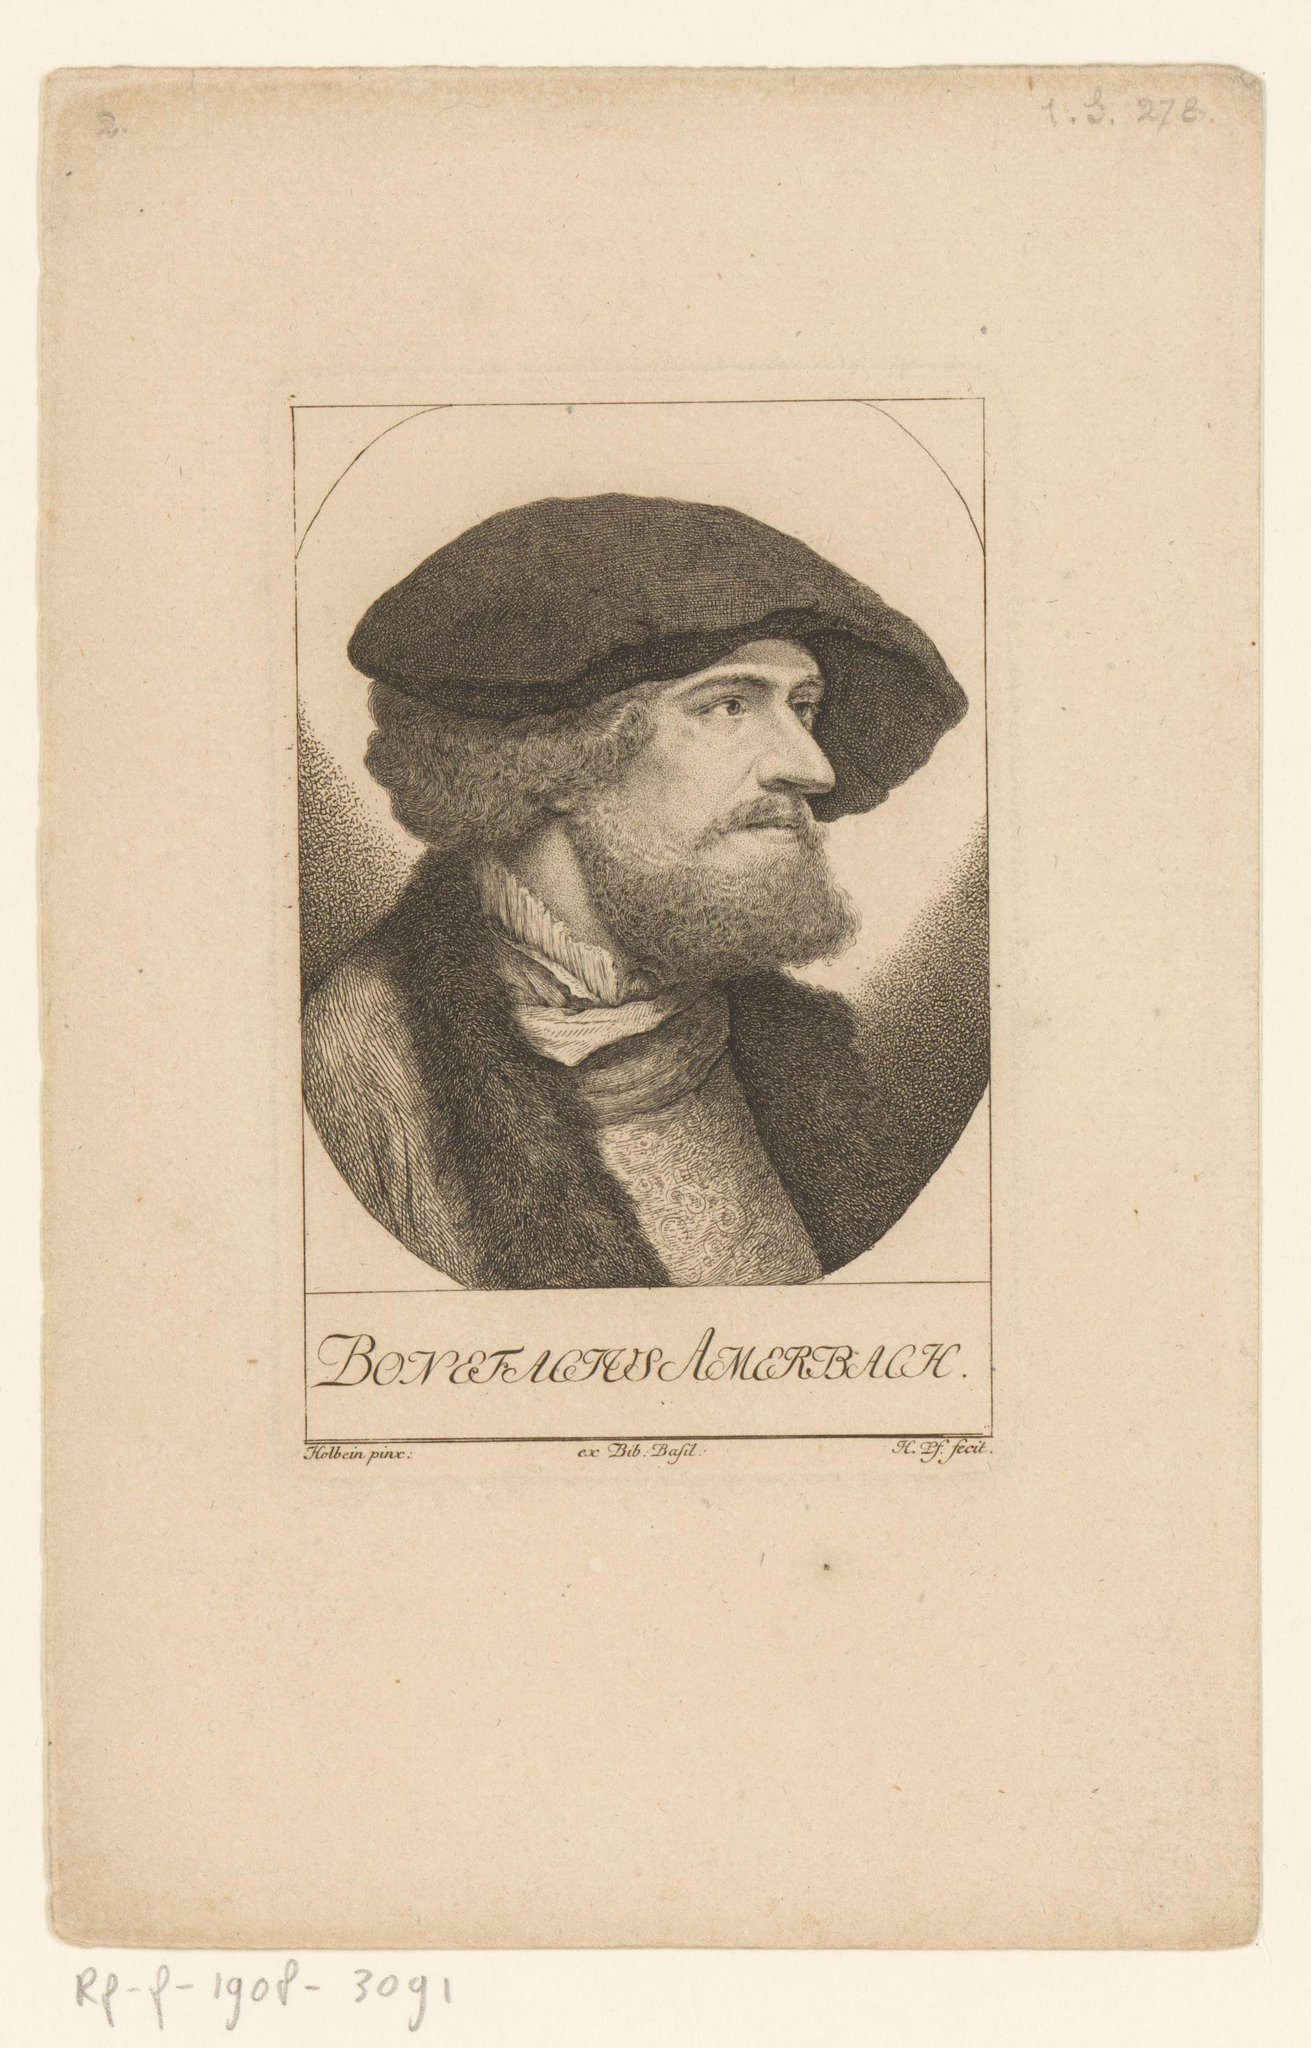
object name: print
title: Portret van Bonefacius Amerbach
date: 1759-1815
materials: paper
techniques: engraving, etching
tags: historical persons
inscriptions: collector's mark: Lugt 2228